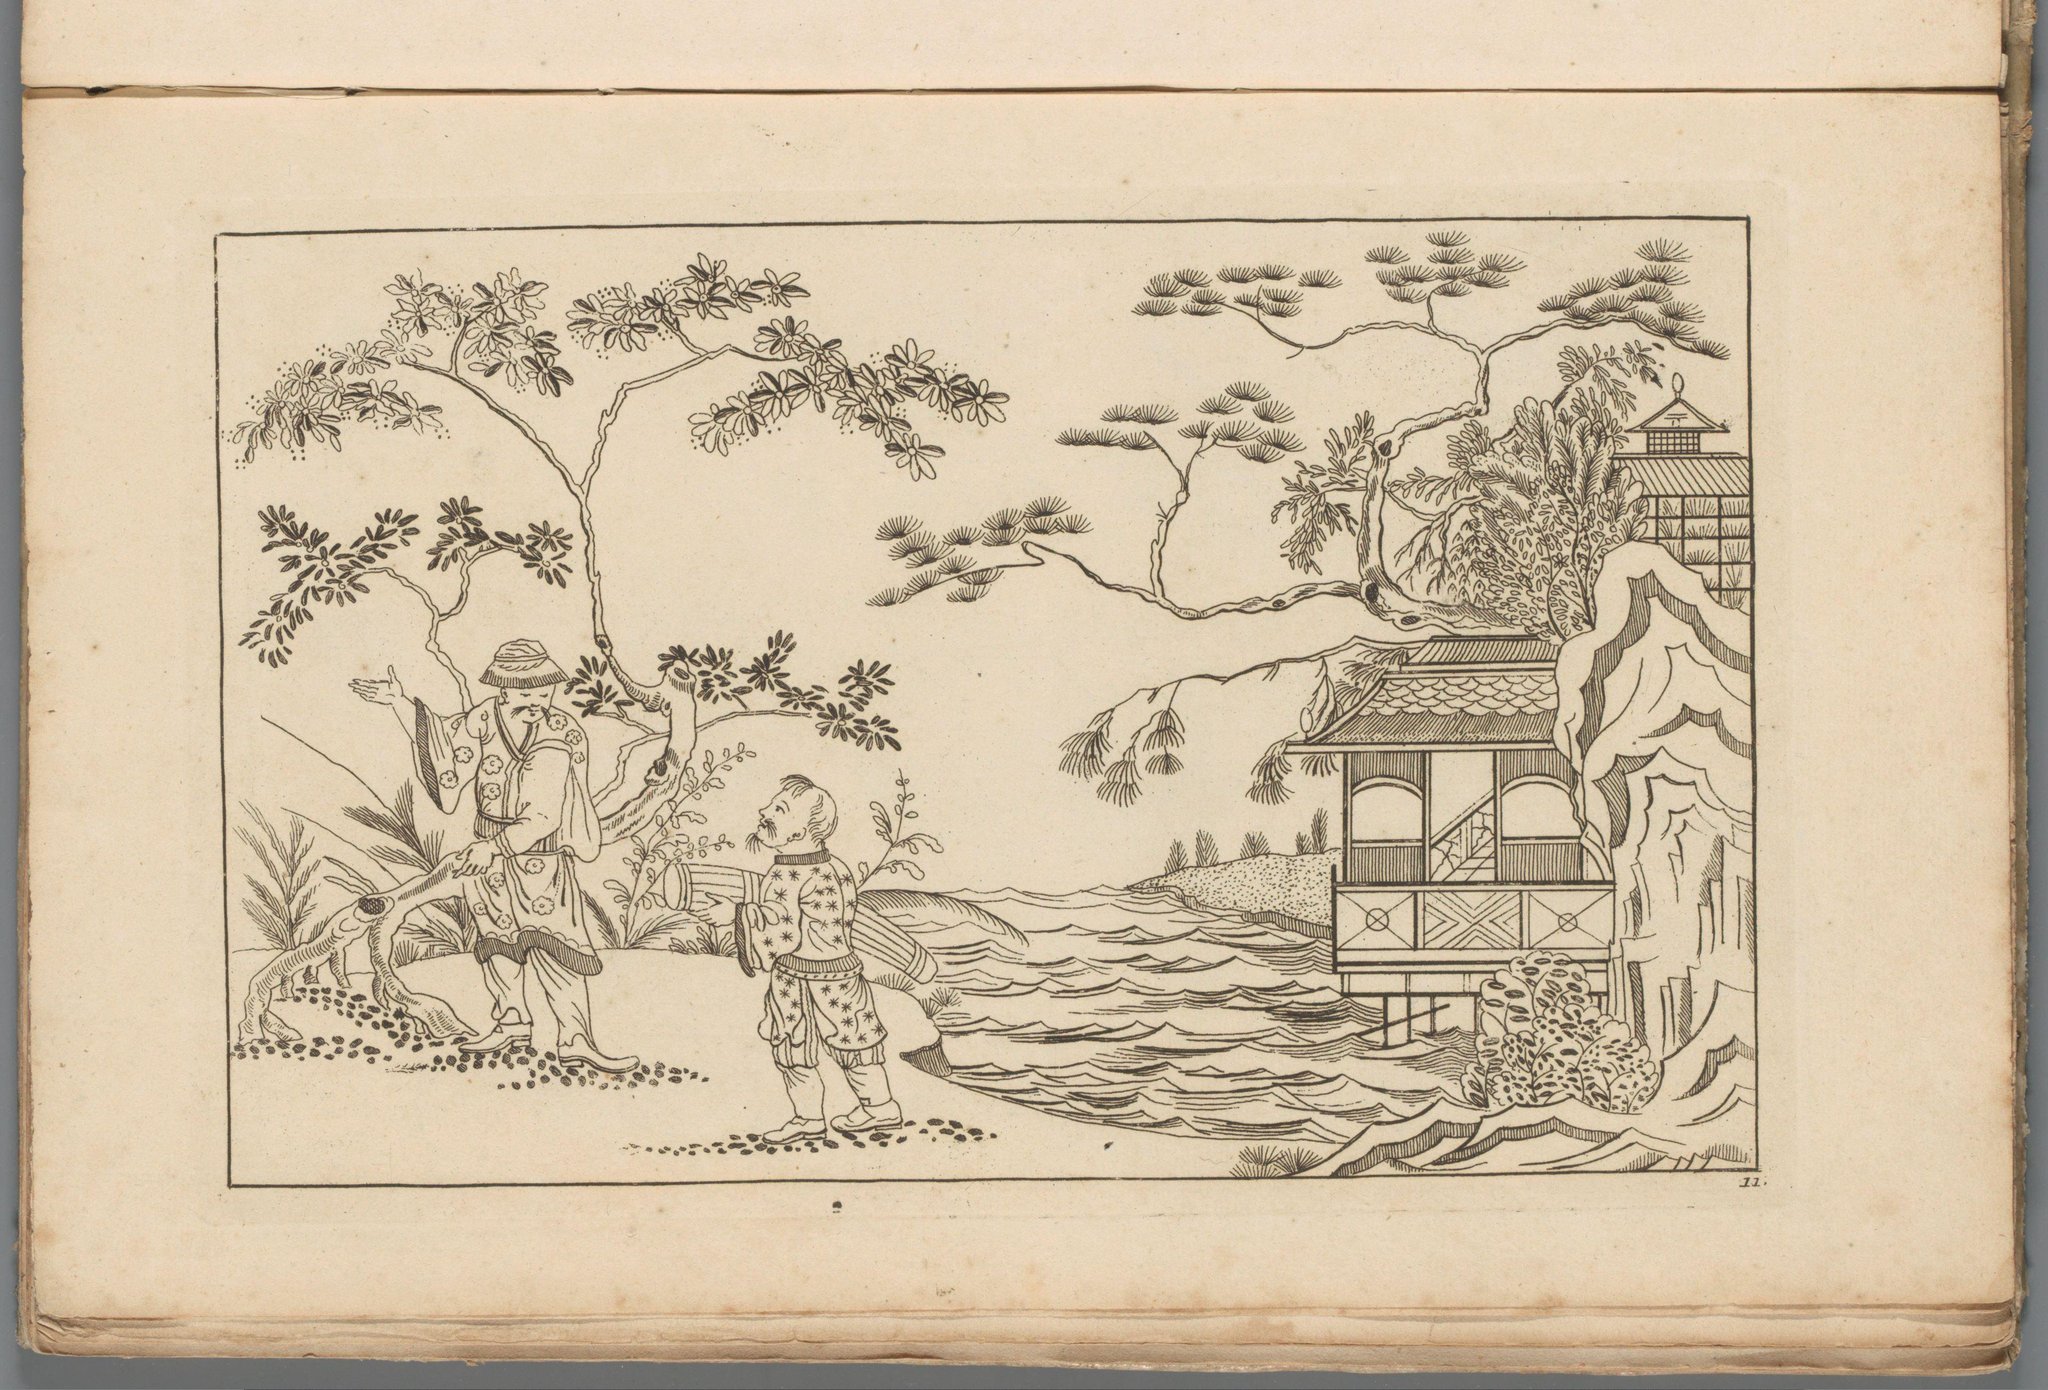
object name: ornament print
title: Nieuwe geinventeerde Sineesen, met groote moeyte geteekent en in 't Ligt gegeven, door P: Schenk Jun (...), eerste deel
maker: pieter schenk (ii)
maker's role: draughtsman, print maker, publisher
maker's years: 1693-1775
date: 1727-1775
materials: paper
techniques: etching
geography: amsterdam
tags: chinese, water course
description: Links twee Chinese mannen in een landschap. In het midden een rivier. Rechts een gebouw. Prent maakt deel uit van een album.